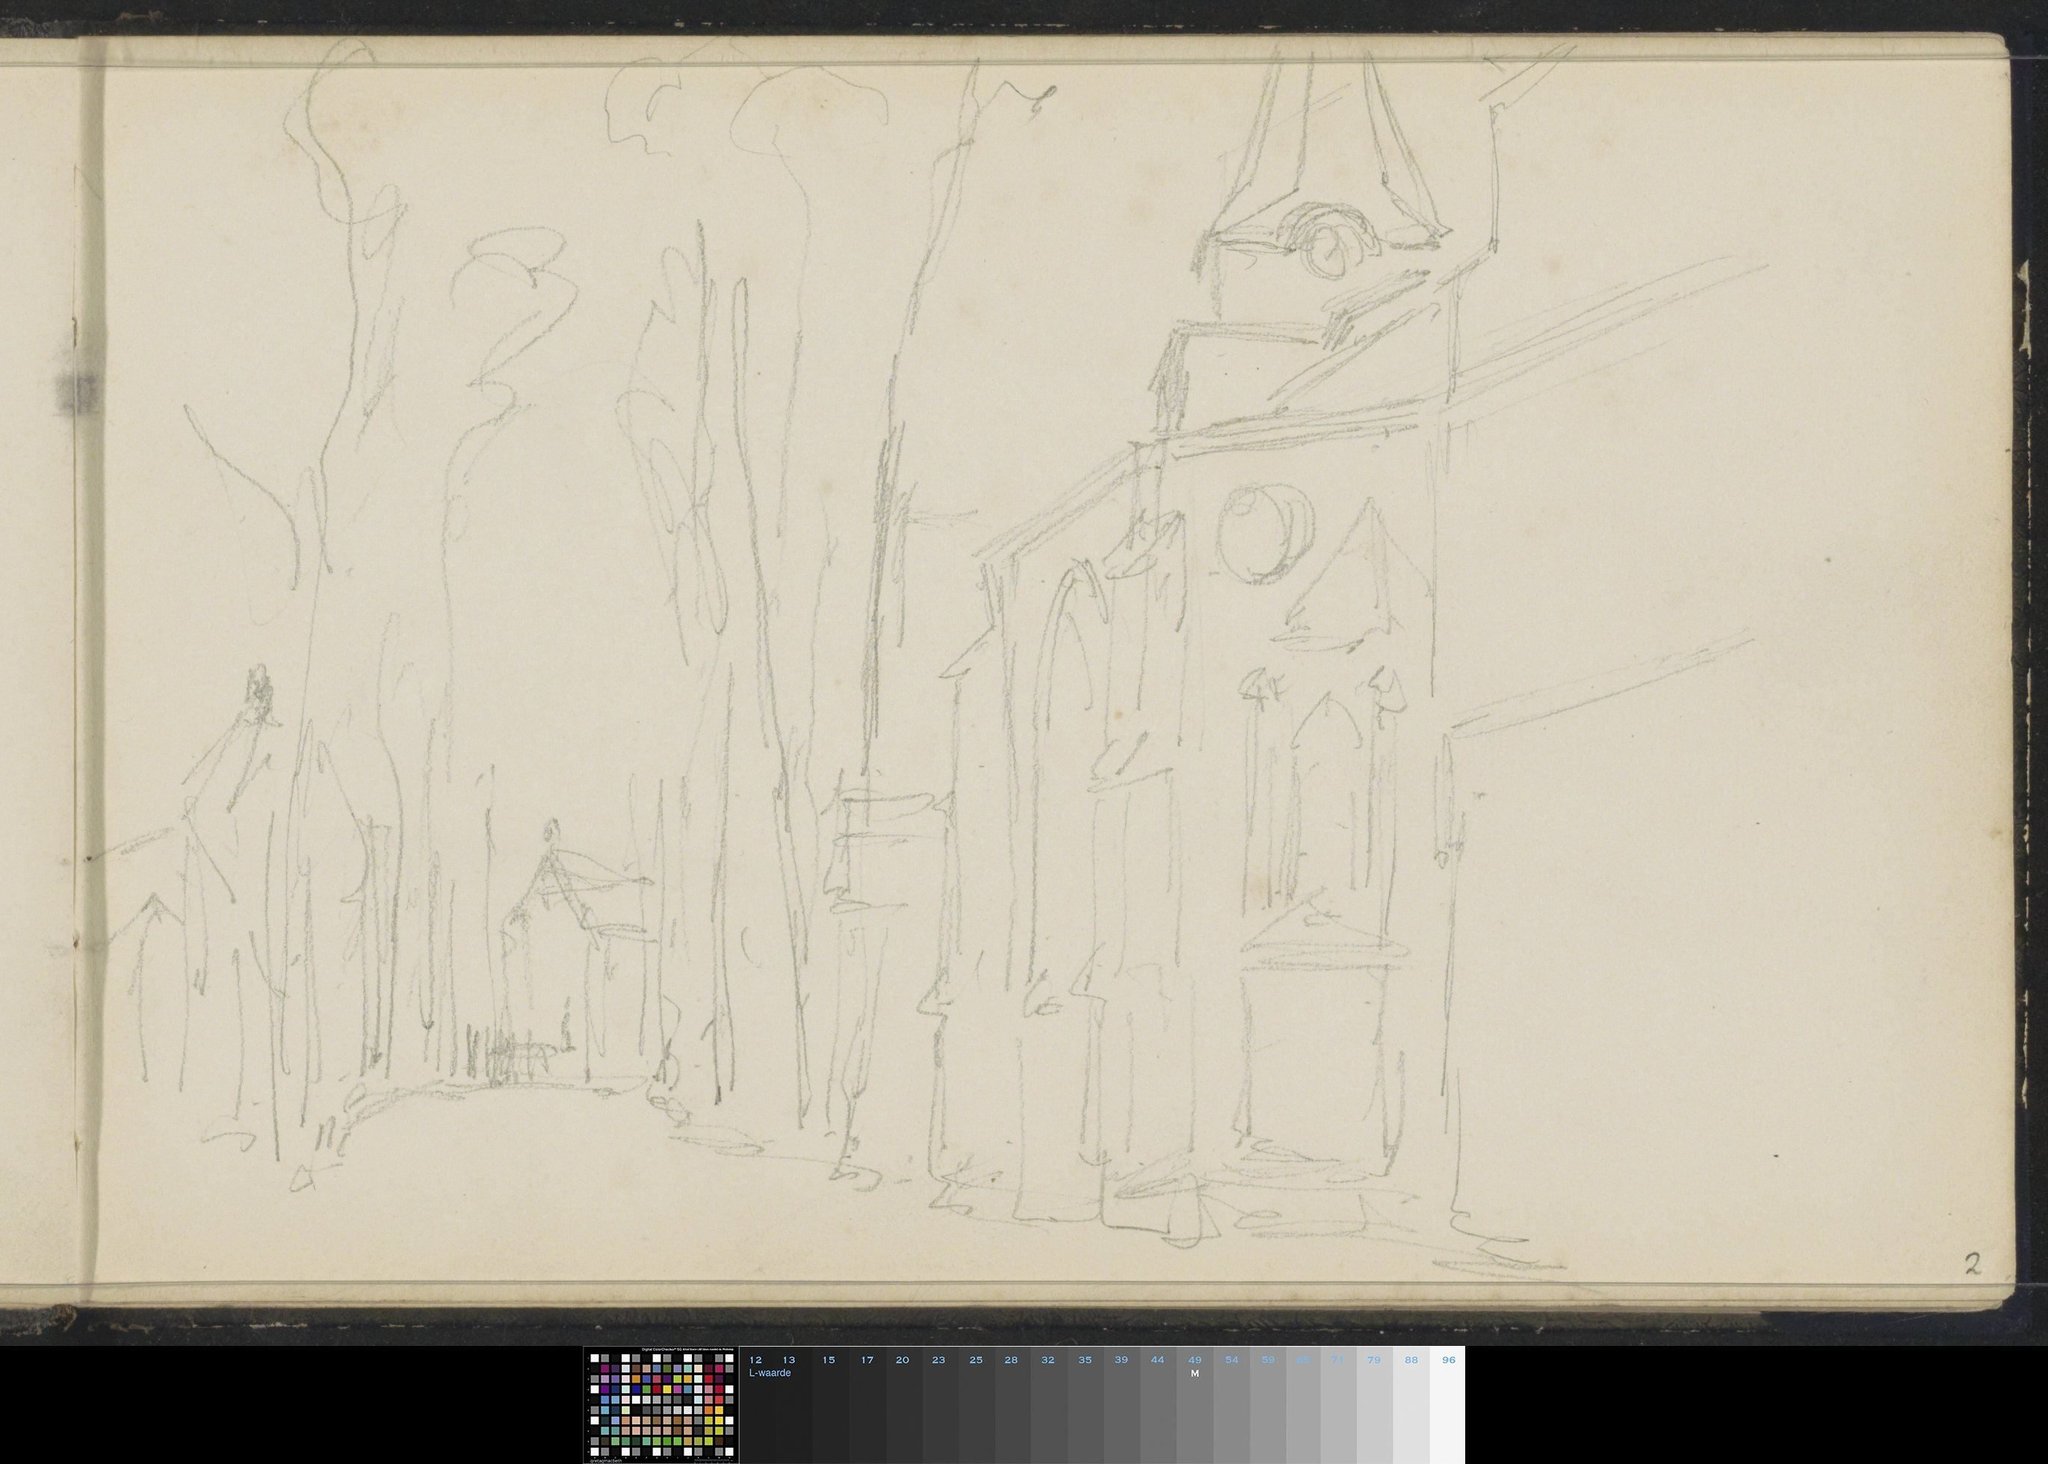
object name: sketchbook leaf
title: Gezicht in Woerden met de Petruskerk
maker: cornelis springer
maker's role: draughtsman, painter, print maker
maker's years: 1817-1891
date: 1870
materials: paper, pencil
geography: woerden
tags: church (exterior), street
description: Gezicht in Woerden met rechts de Petruskerk. Blad 2 recto uit een schetsboek met 40 bladen, vervaardigd in Woerden en Gouda.